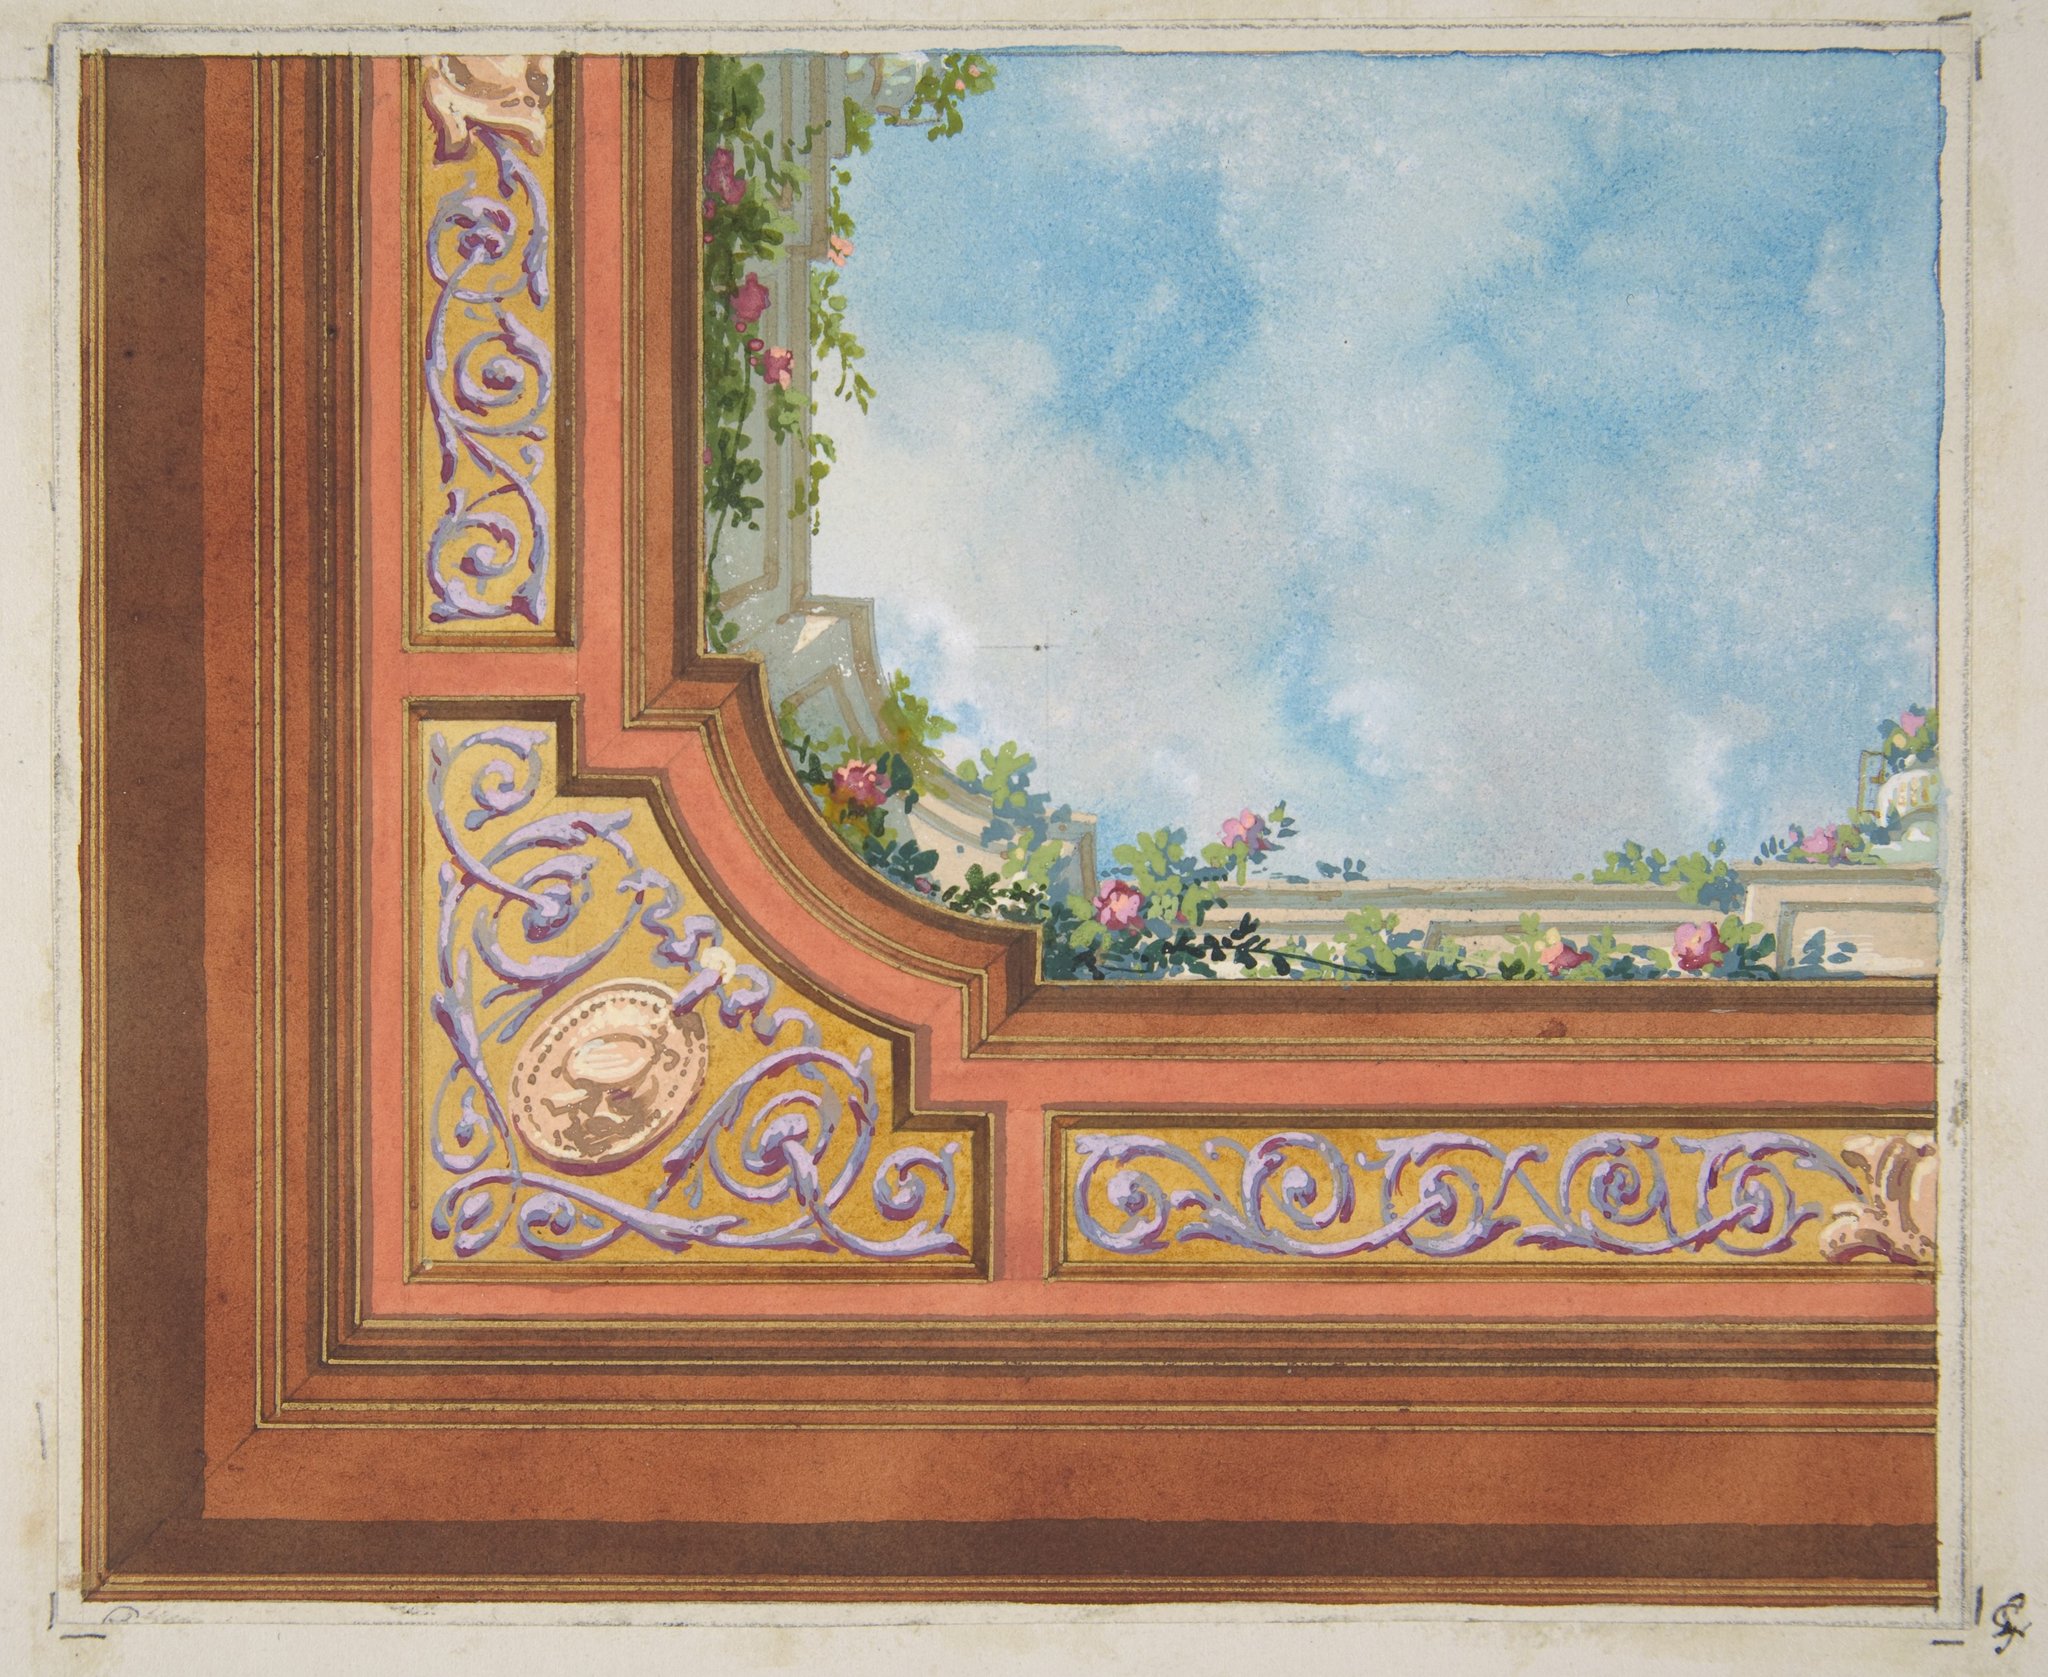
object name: drawing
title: Partial design for ceiling decoration with clouds and roses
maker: jules-edmond-charles lachaise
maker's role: artist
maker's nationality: french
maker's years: 1897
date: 1830-1897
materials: gold paint, gouache, watercolor, paper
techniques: inlay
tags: roses,clouds,ceilings